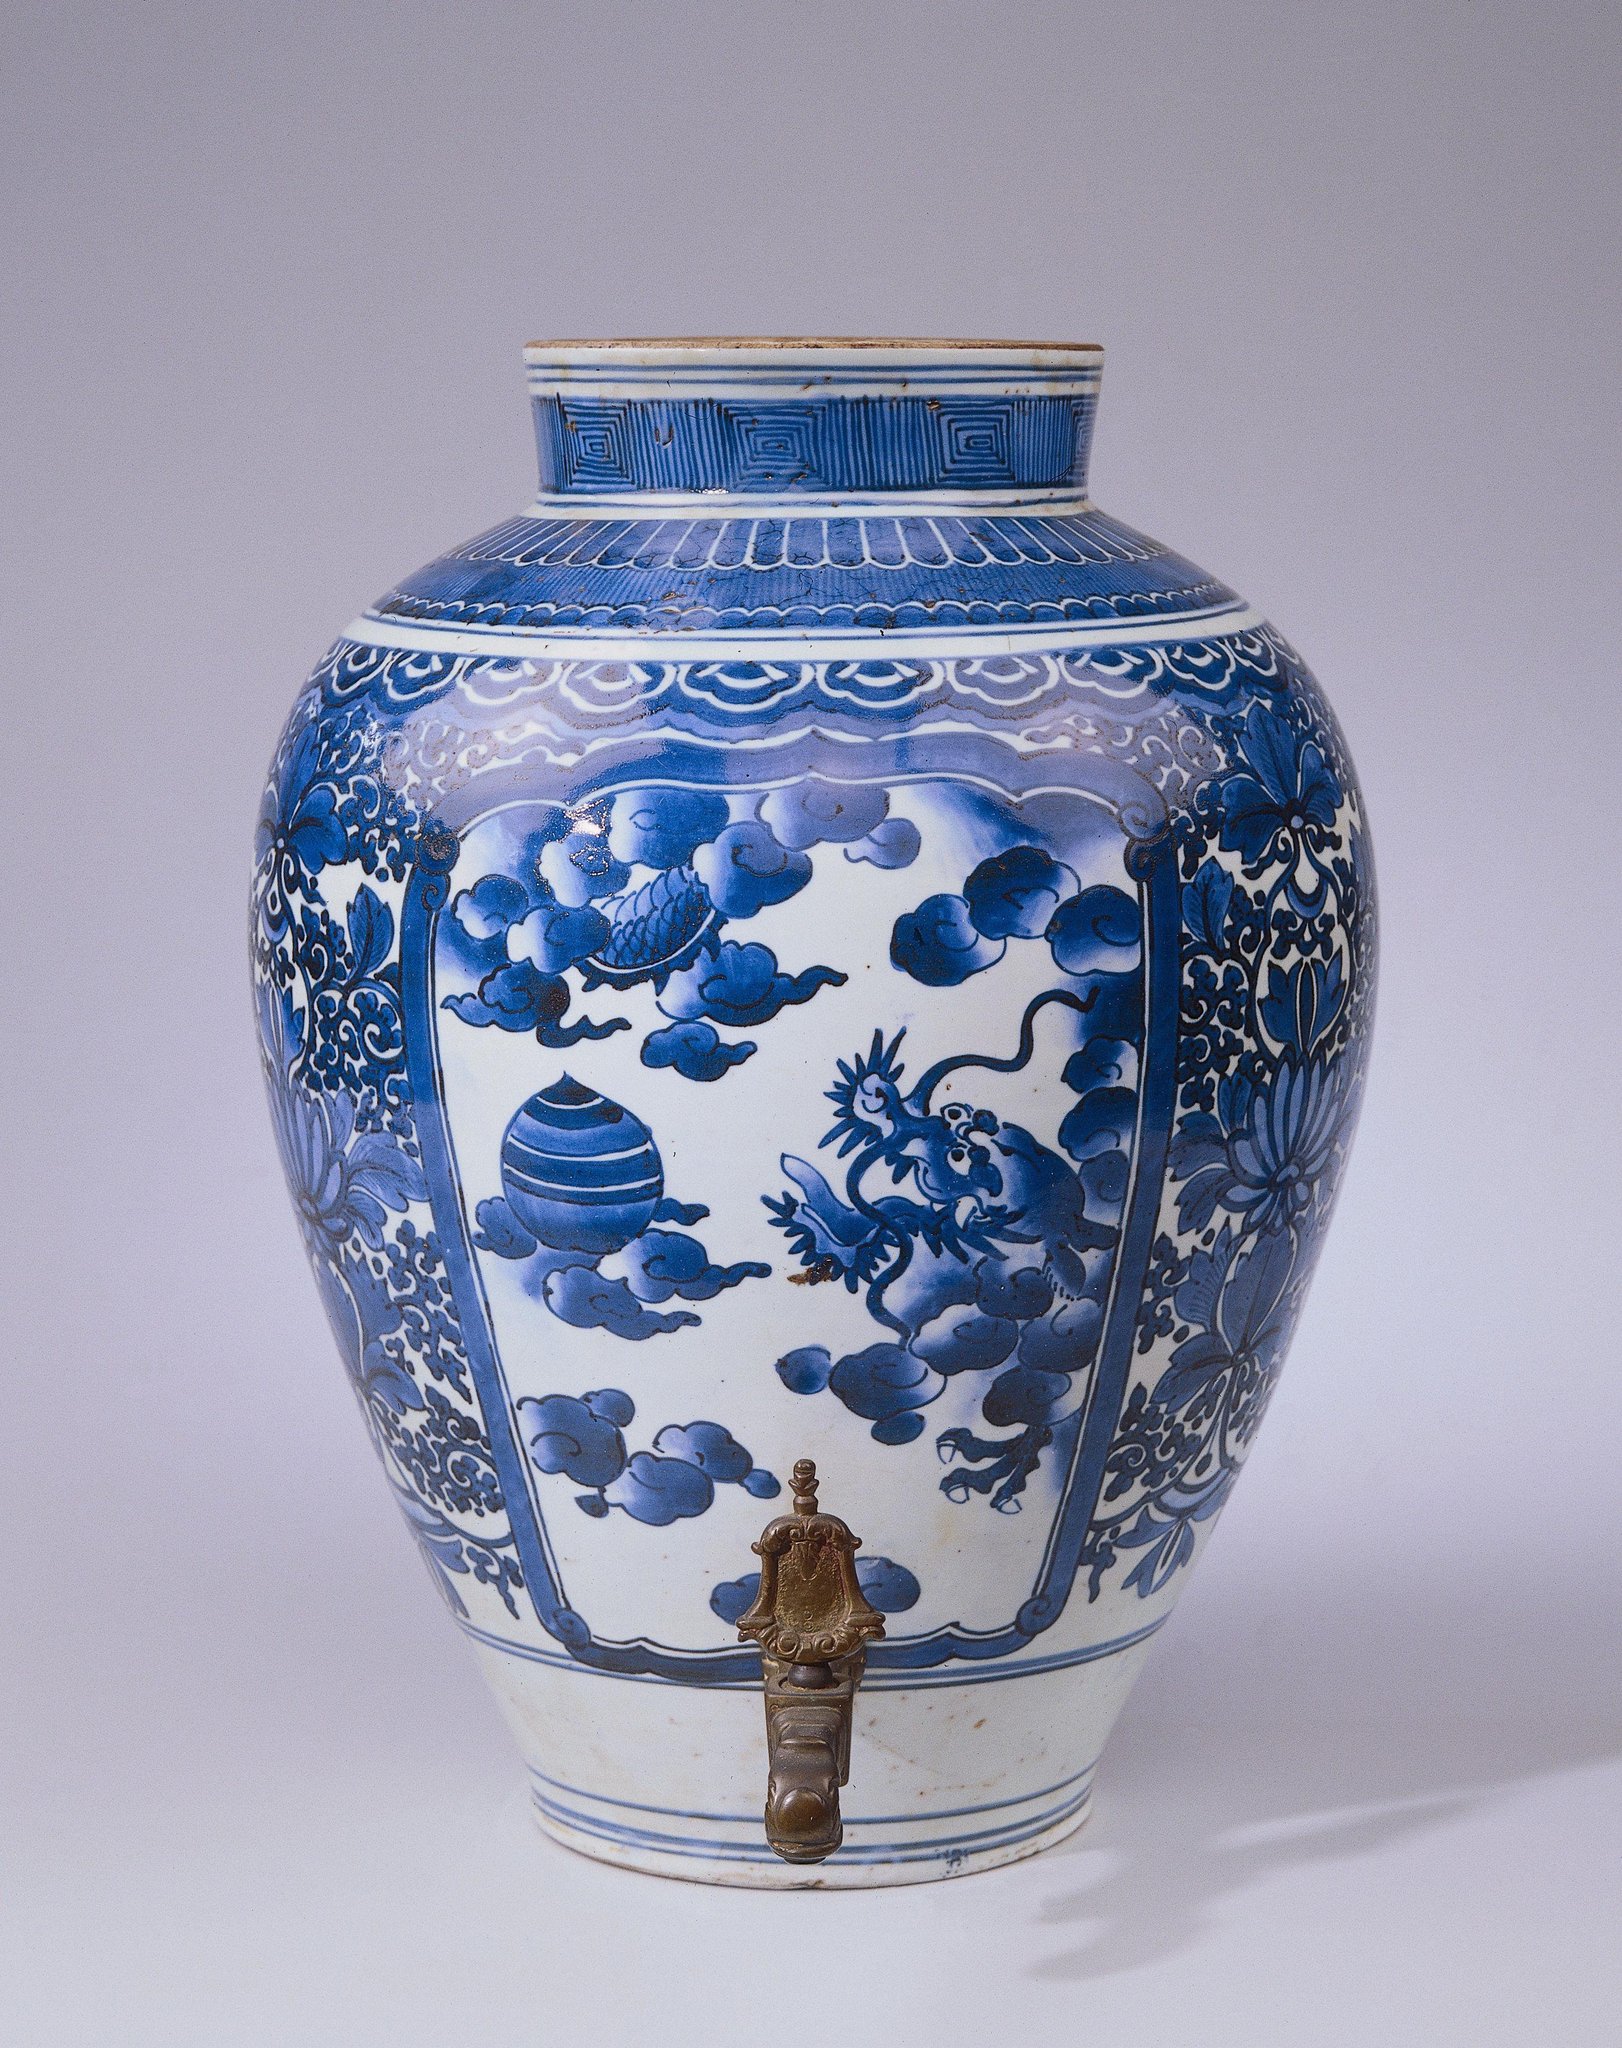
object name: pot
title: Eivormige pot (fonteinpot) met rots en planten en bloemen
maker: Anonymous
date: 1675-1700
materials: brass, cobalt, glaze, paint, porcelain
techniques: firing, turning, vitrification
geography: arita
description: Pot, onderglazuur blauw, met kraantje met perken en swastikamotieven. Kraan later toegevoegd.